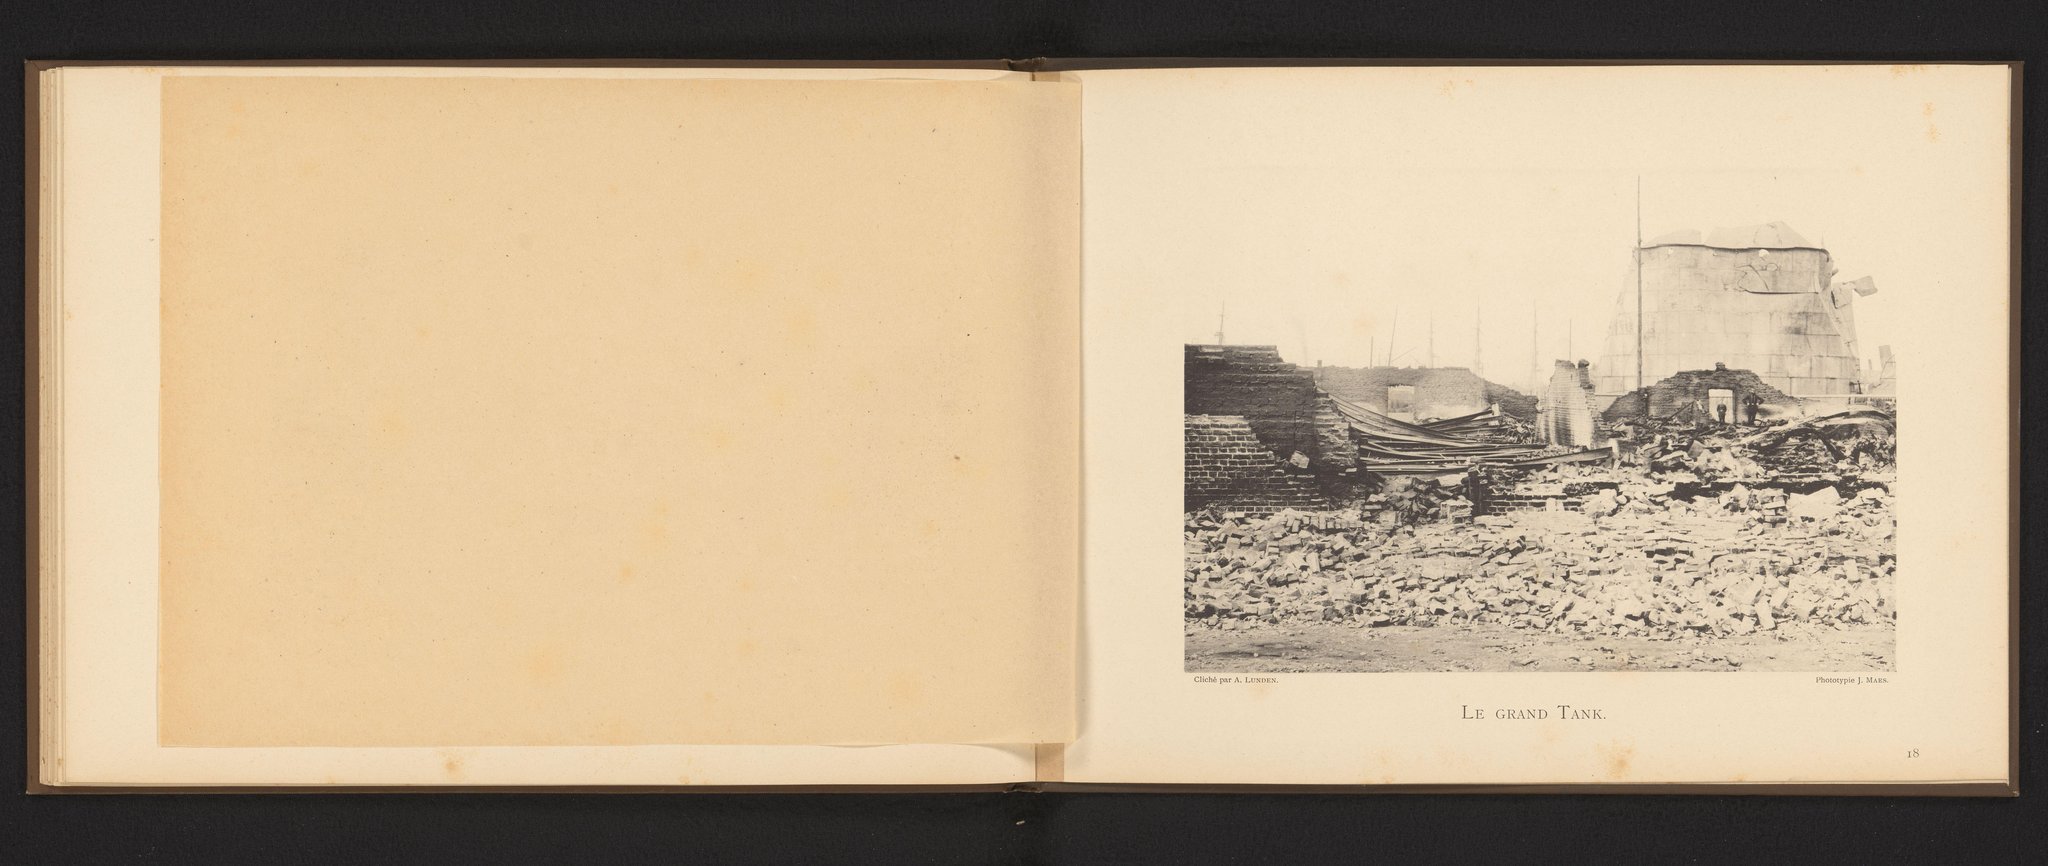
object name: page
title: Le grand tank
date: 1889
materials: paper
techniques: photograph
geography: antwerp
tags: ruin of a building ~ architecture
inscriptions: number: ‘18’